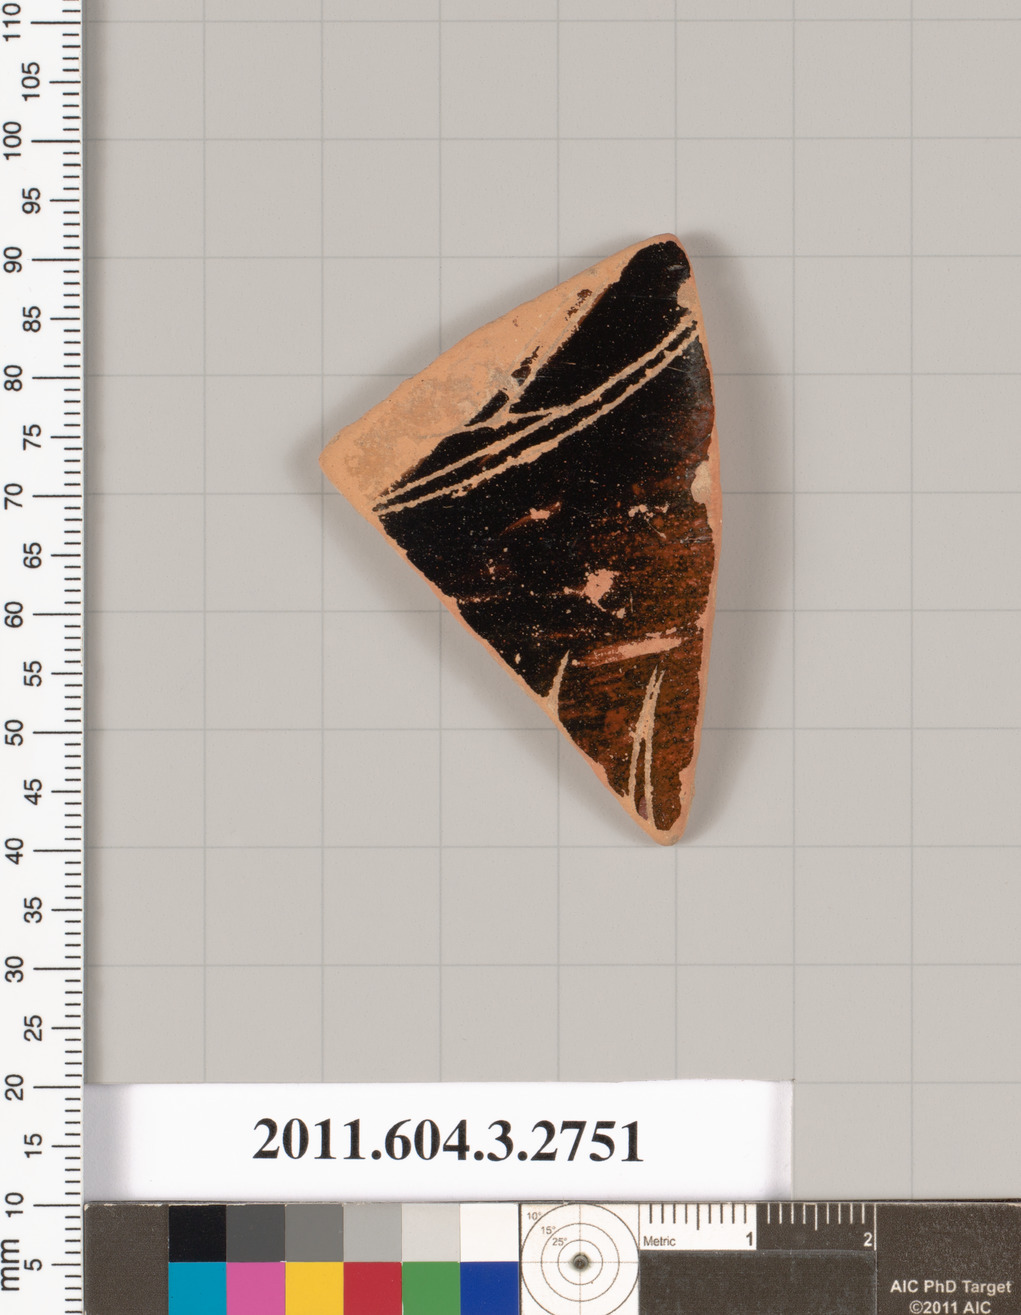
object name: oinochoe or olpe fragment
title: Terracotta fragment of an oinochoe (jug) or olpe (jug)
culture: greek, attic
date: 525-501 BCE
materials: terracotta